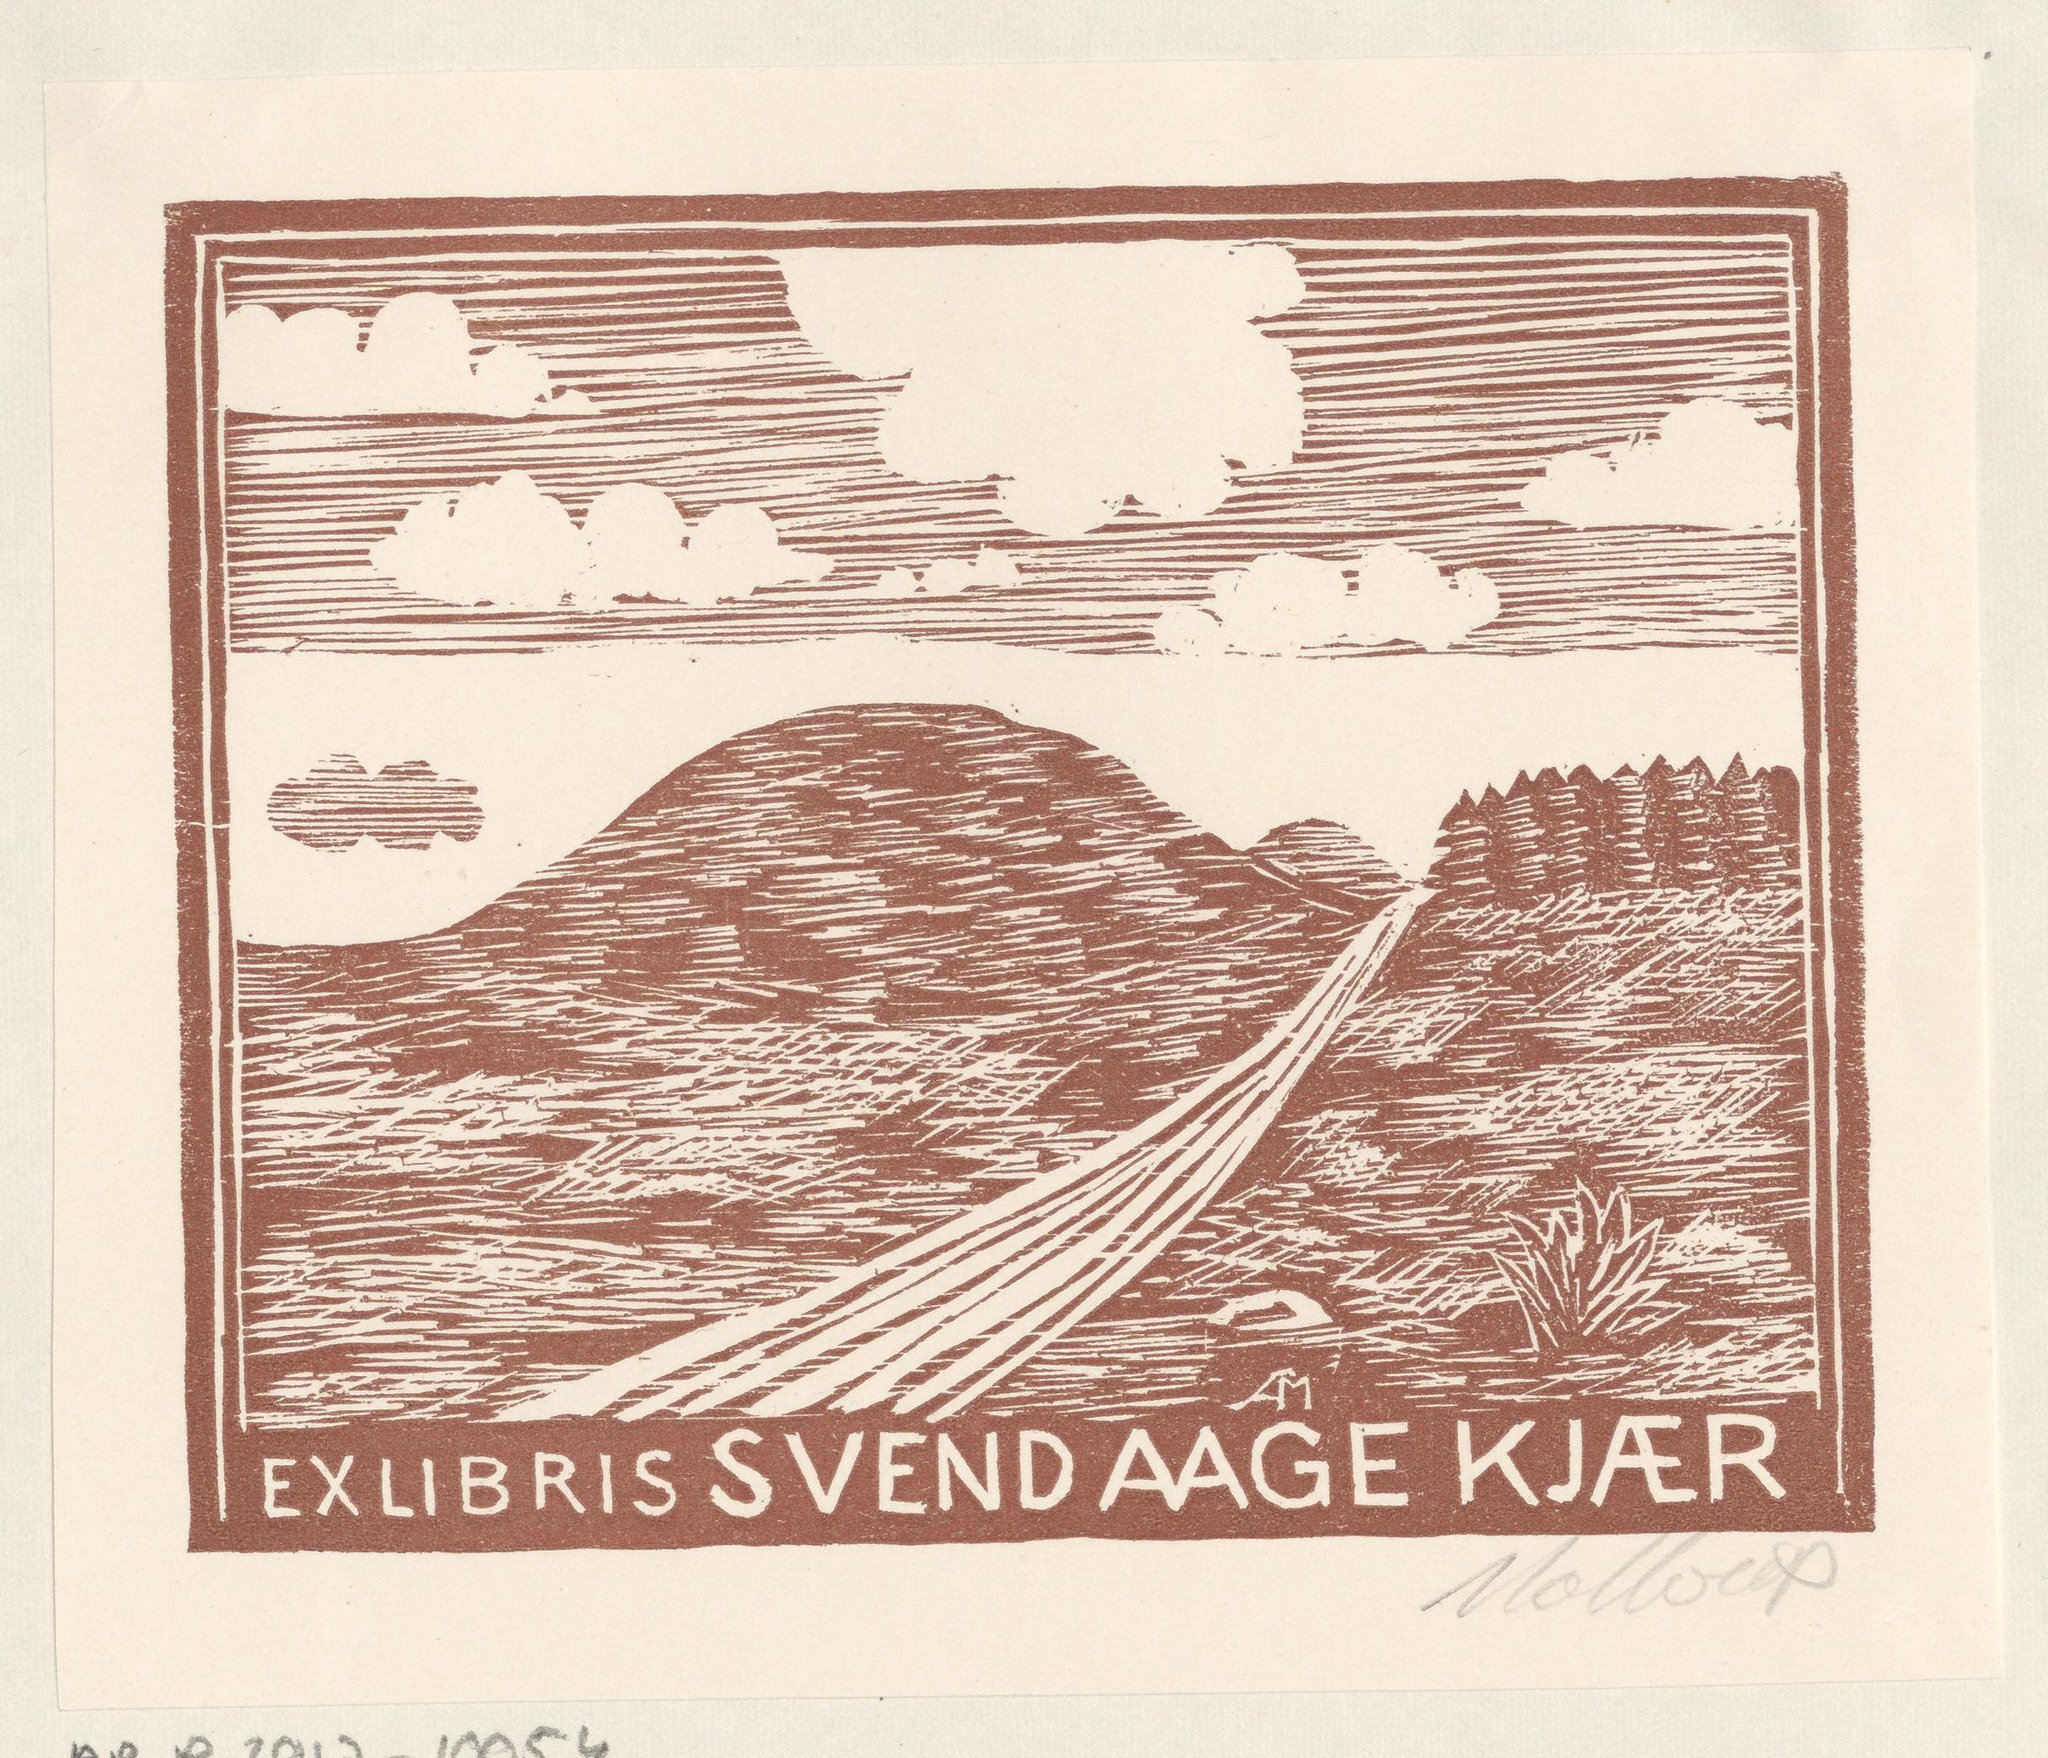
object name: bookplate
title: Ex libris van Svend Aage Kjær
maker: svend aage mollerup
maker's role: print maker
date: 1900-1999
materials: paper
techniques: woodcut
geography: denmark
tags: landscapes, road, path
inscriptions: workshop stamp: ‘Sv. Aage Mollerup/ Danmark/ Woodcur - bois de fil’